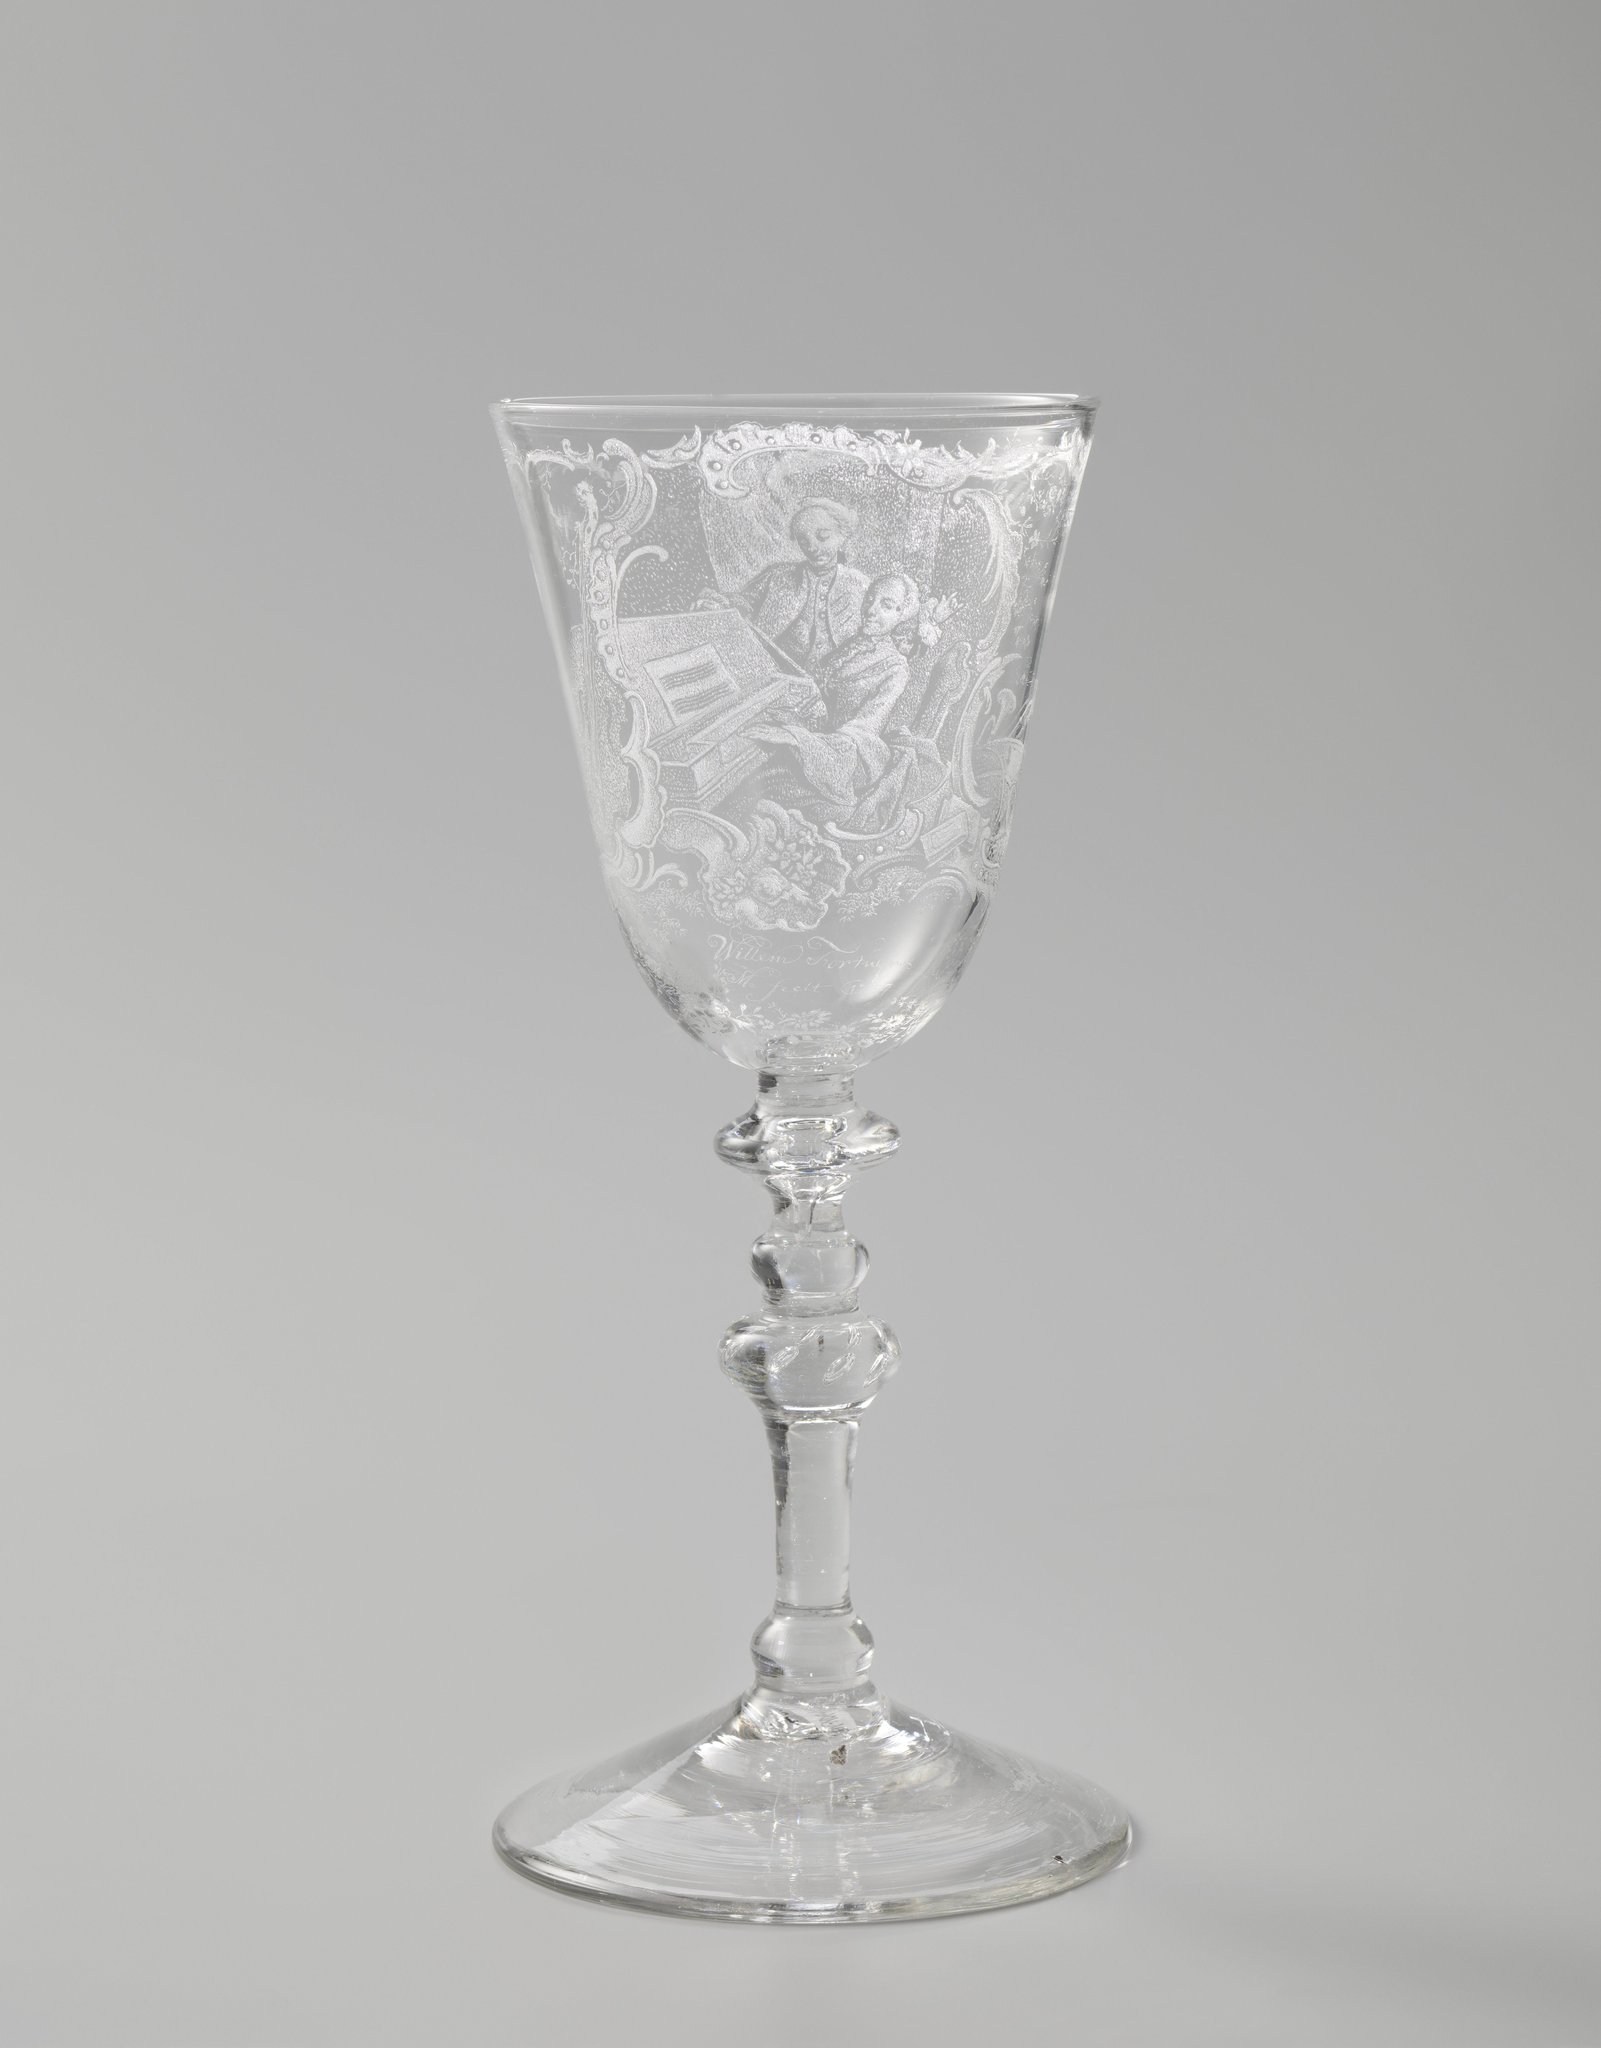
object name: goblet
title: Wine glass with a woman at a spinet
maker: willem fortuyn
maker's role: print maker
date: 1757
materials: glass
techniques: glassblowing, engraving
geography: northern netherlands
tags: one person playing keyboard instrument, spinet, virginal, ornament ~ cartouche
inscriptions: signature and date: ‘Willem Fortuyn Me fecit 1757’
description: Musicerende dame en heer, 1757. Bruikleen Koninklijk Oudheidkundig Genootschap.